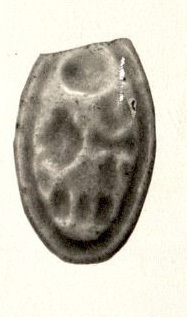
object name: ring bezel, ankhkheperure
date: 1352-1336 BCE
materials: faience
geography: egypt